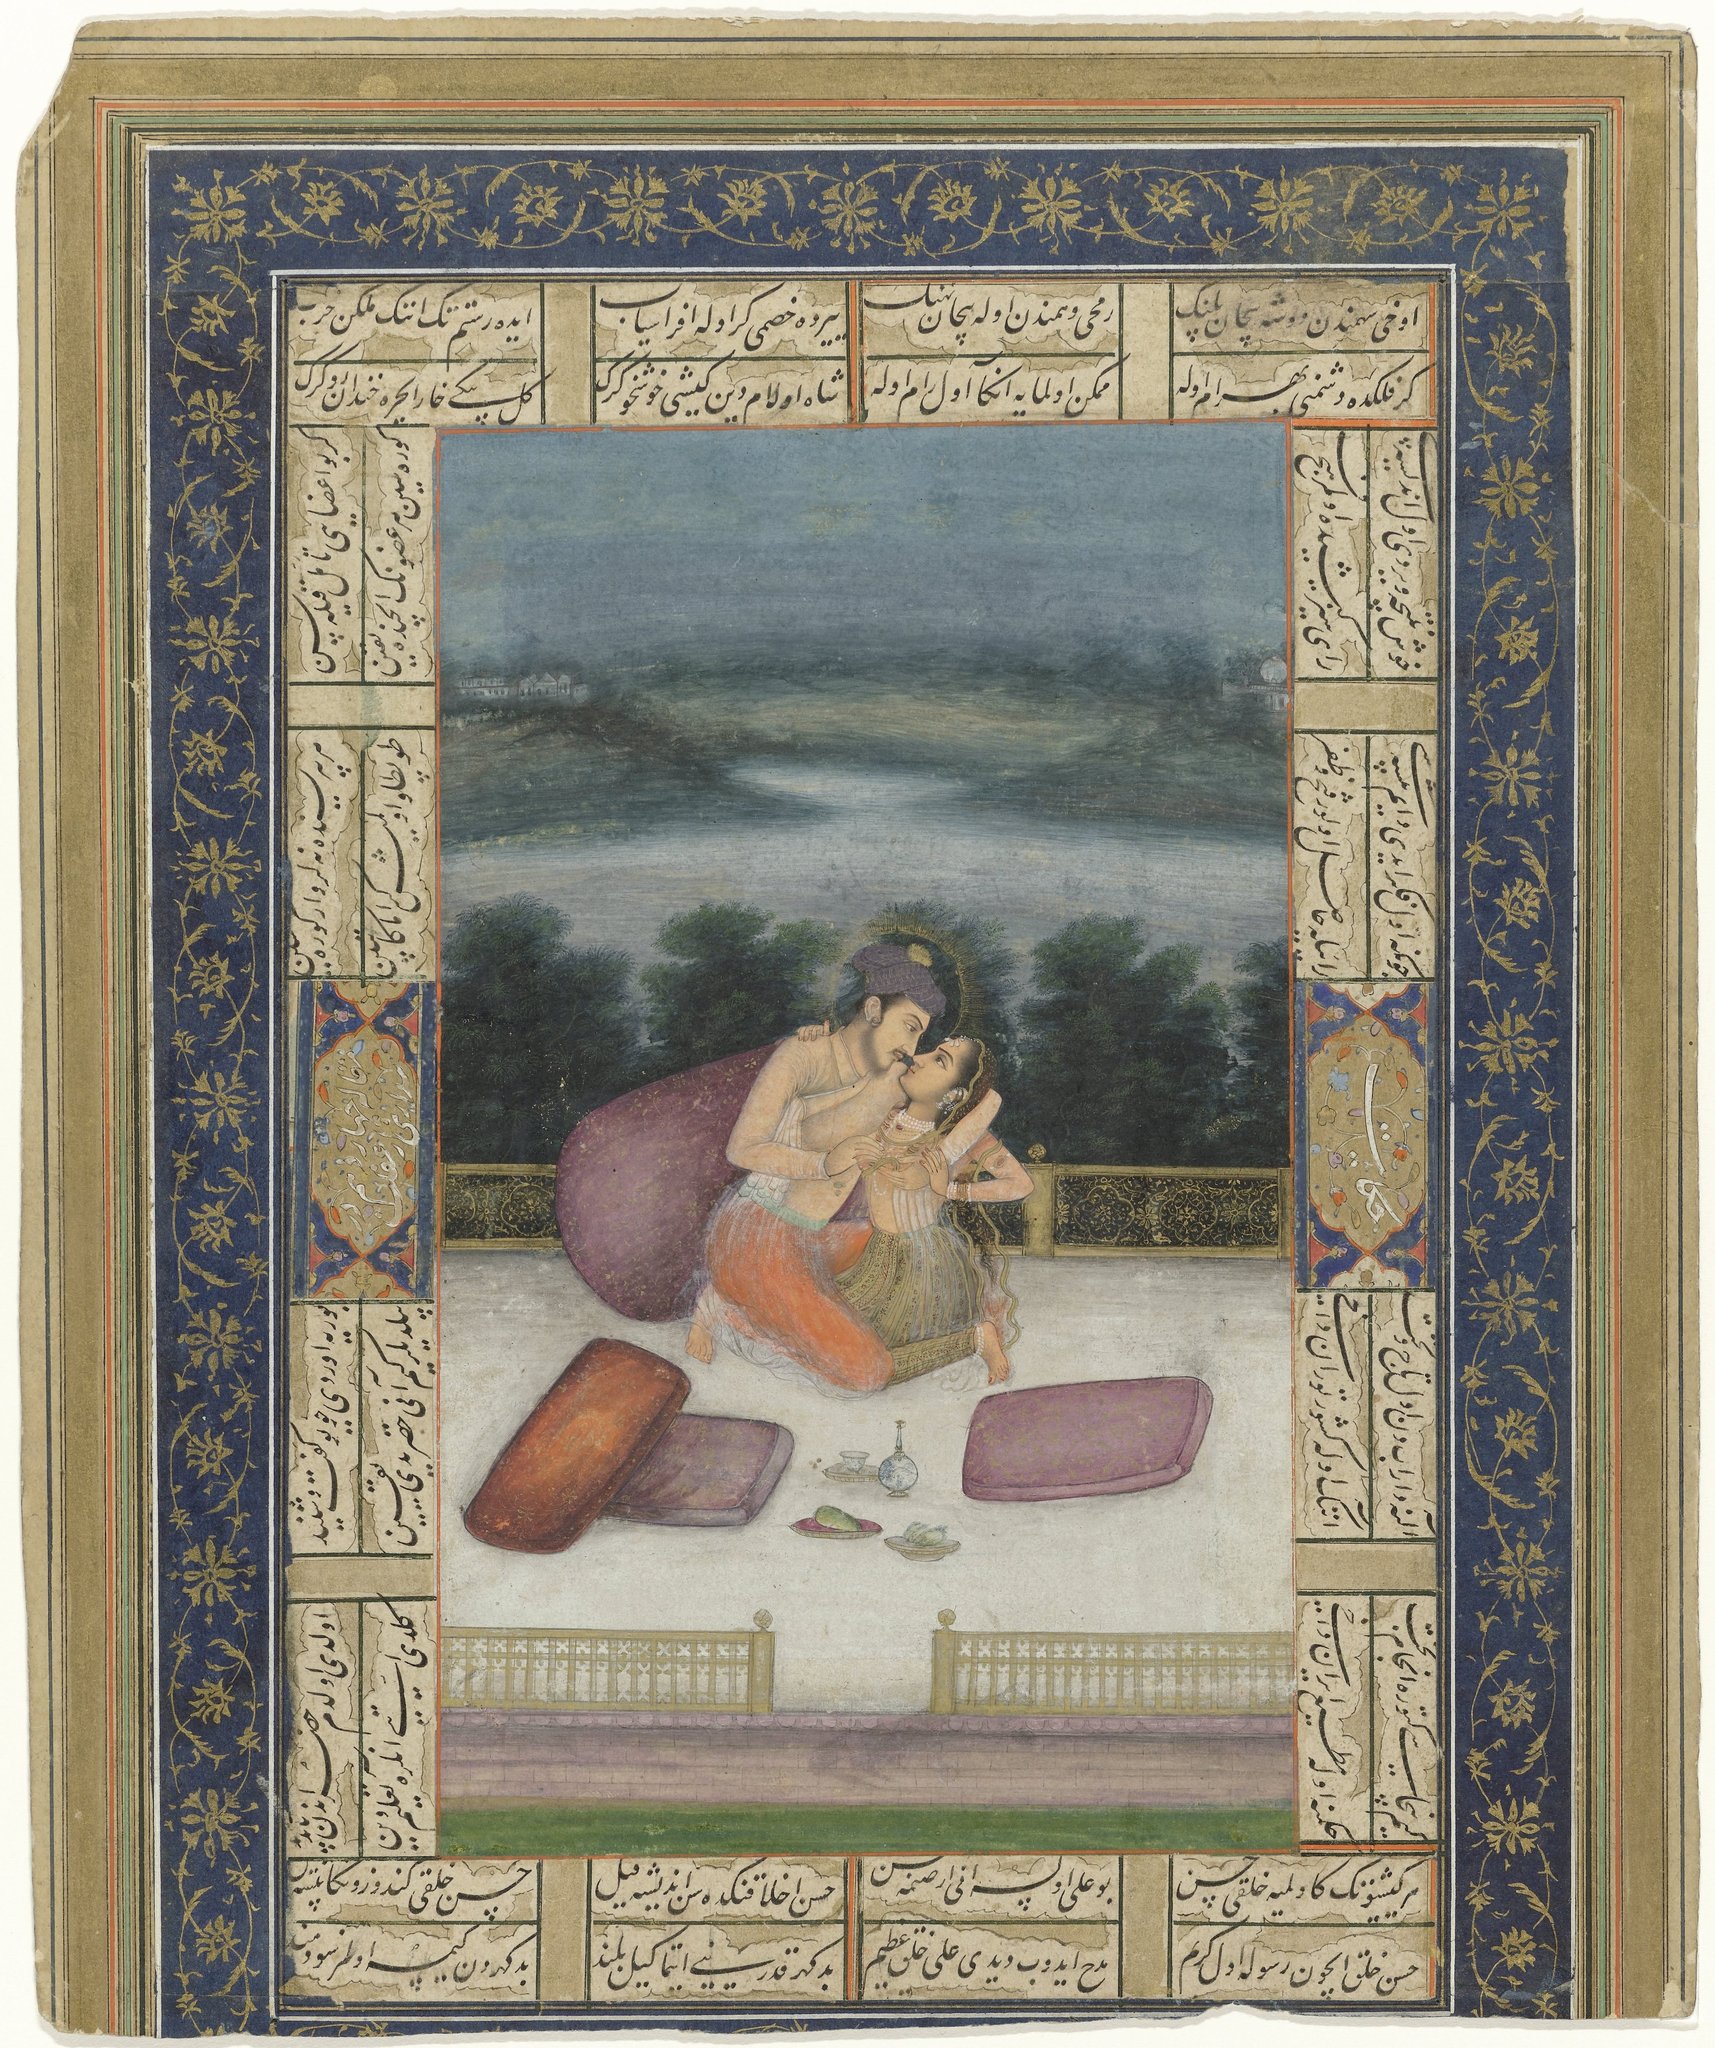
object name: drawing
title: Elkaar omhelzend paar op een terras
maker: Anonymous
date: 1740-1760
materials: paper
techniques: brush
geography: india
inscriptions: inscription: ‘.’